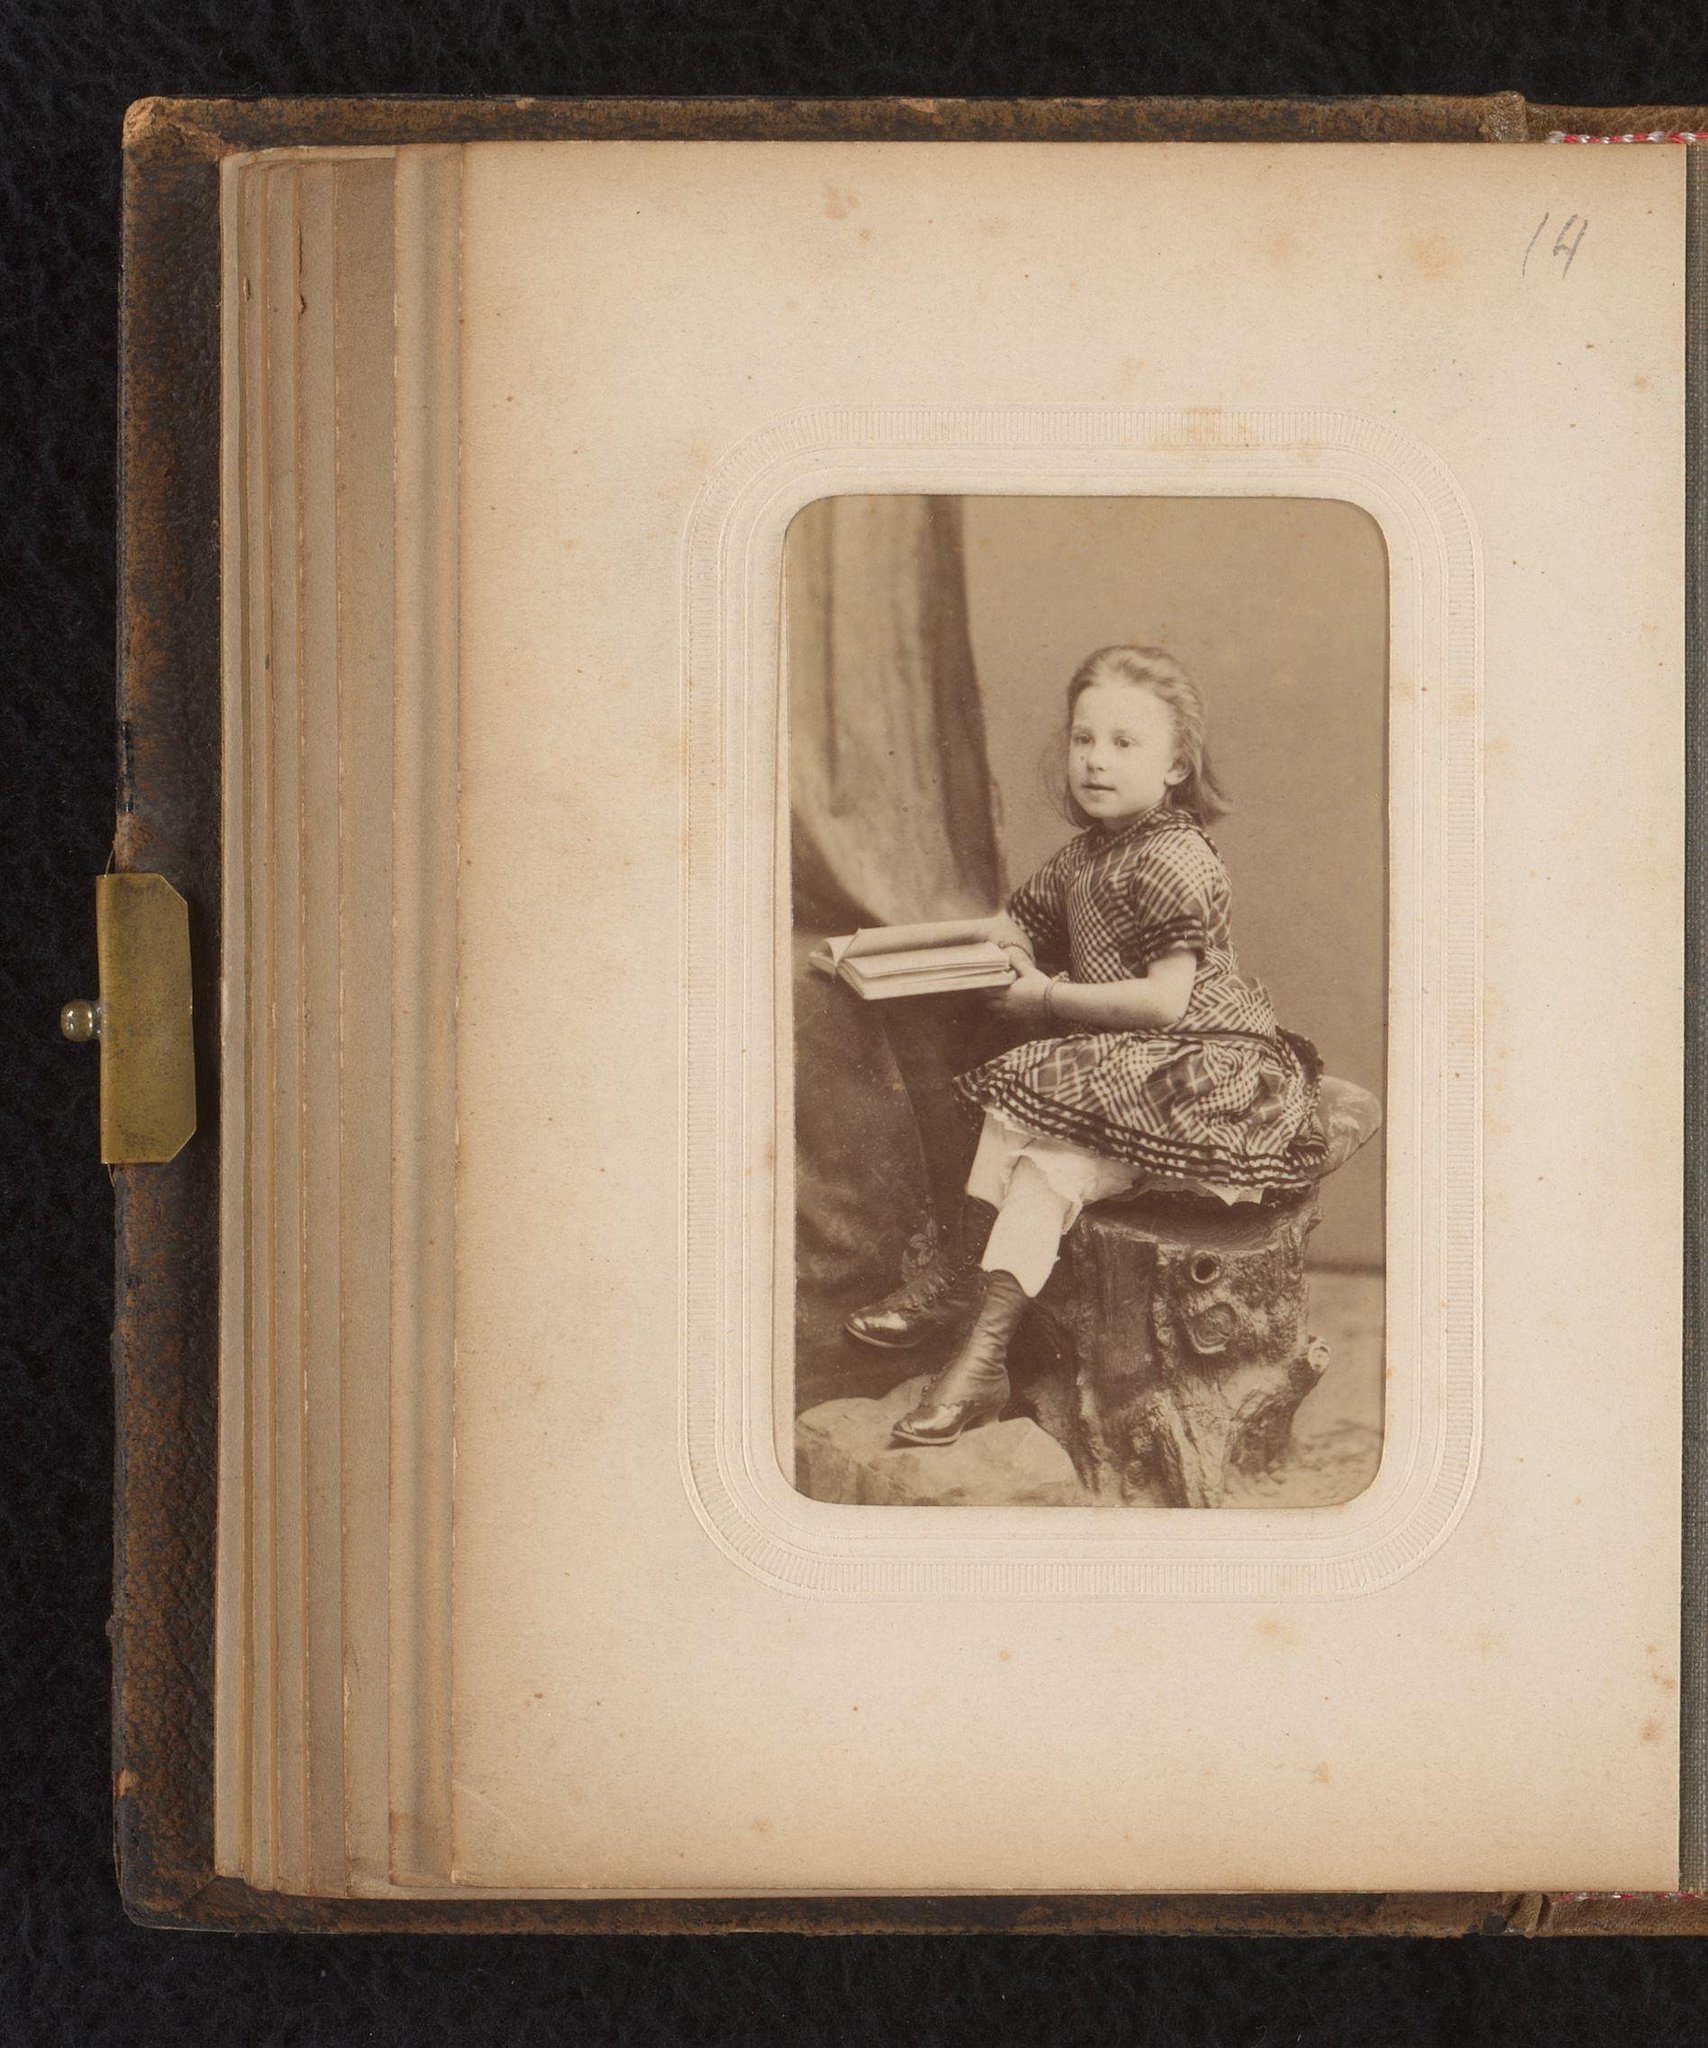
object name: carte de visite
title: Portret van Cornelia Maria Bon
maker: louis robert werner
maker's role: fotograaf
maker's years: 1834-1896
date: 1883-1888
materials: cardboard, paper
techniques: albumen print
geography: amsterdam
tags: historical persons - bb - woman, girl (child between toddler and youth)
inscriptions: inscription: ‘L.R. Werner/ voorheen P. Carstensen/ Amsterdam/ Nieuwendyk H.150. (...) geleverd worden.’